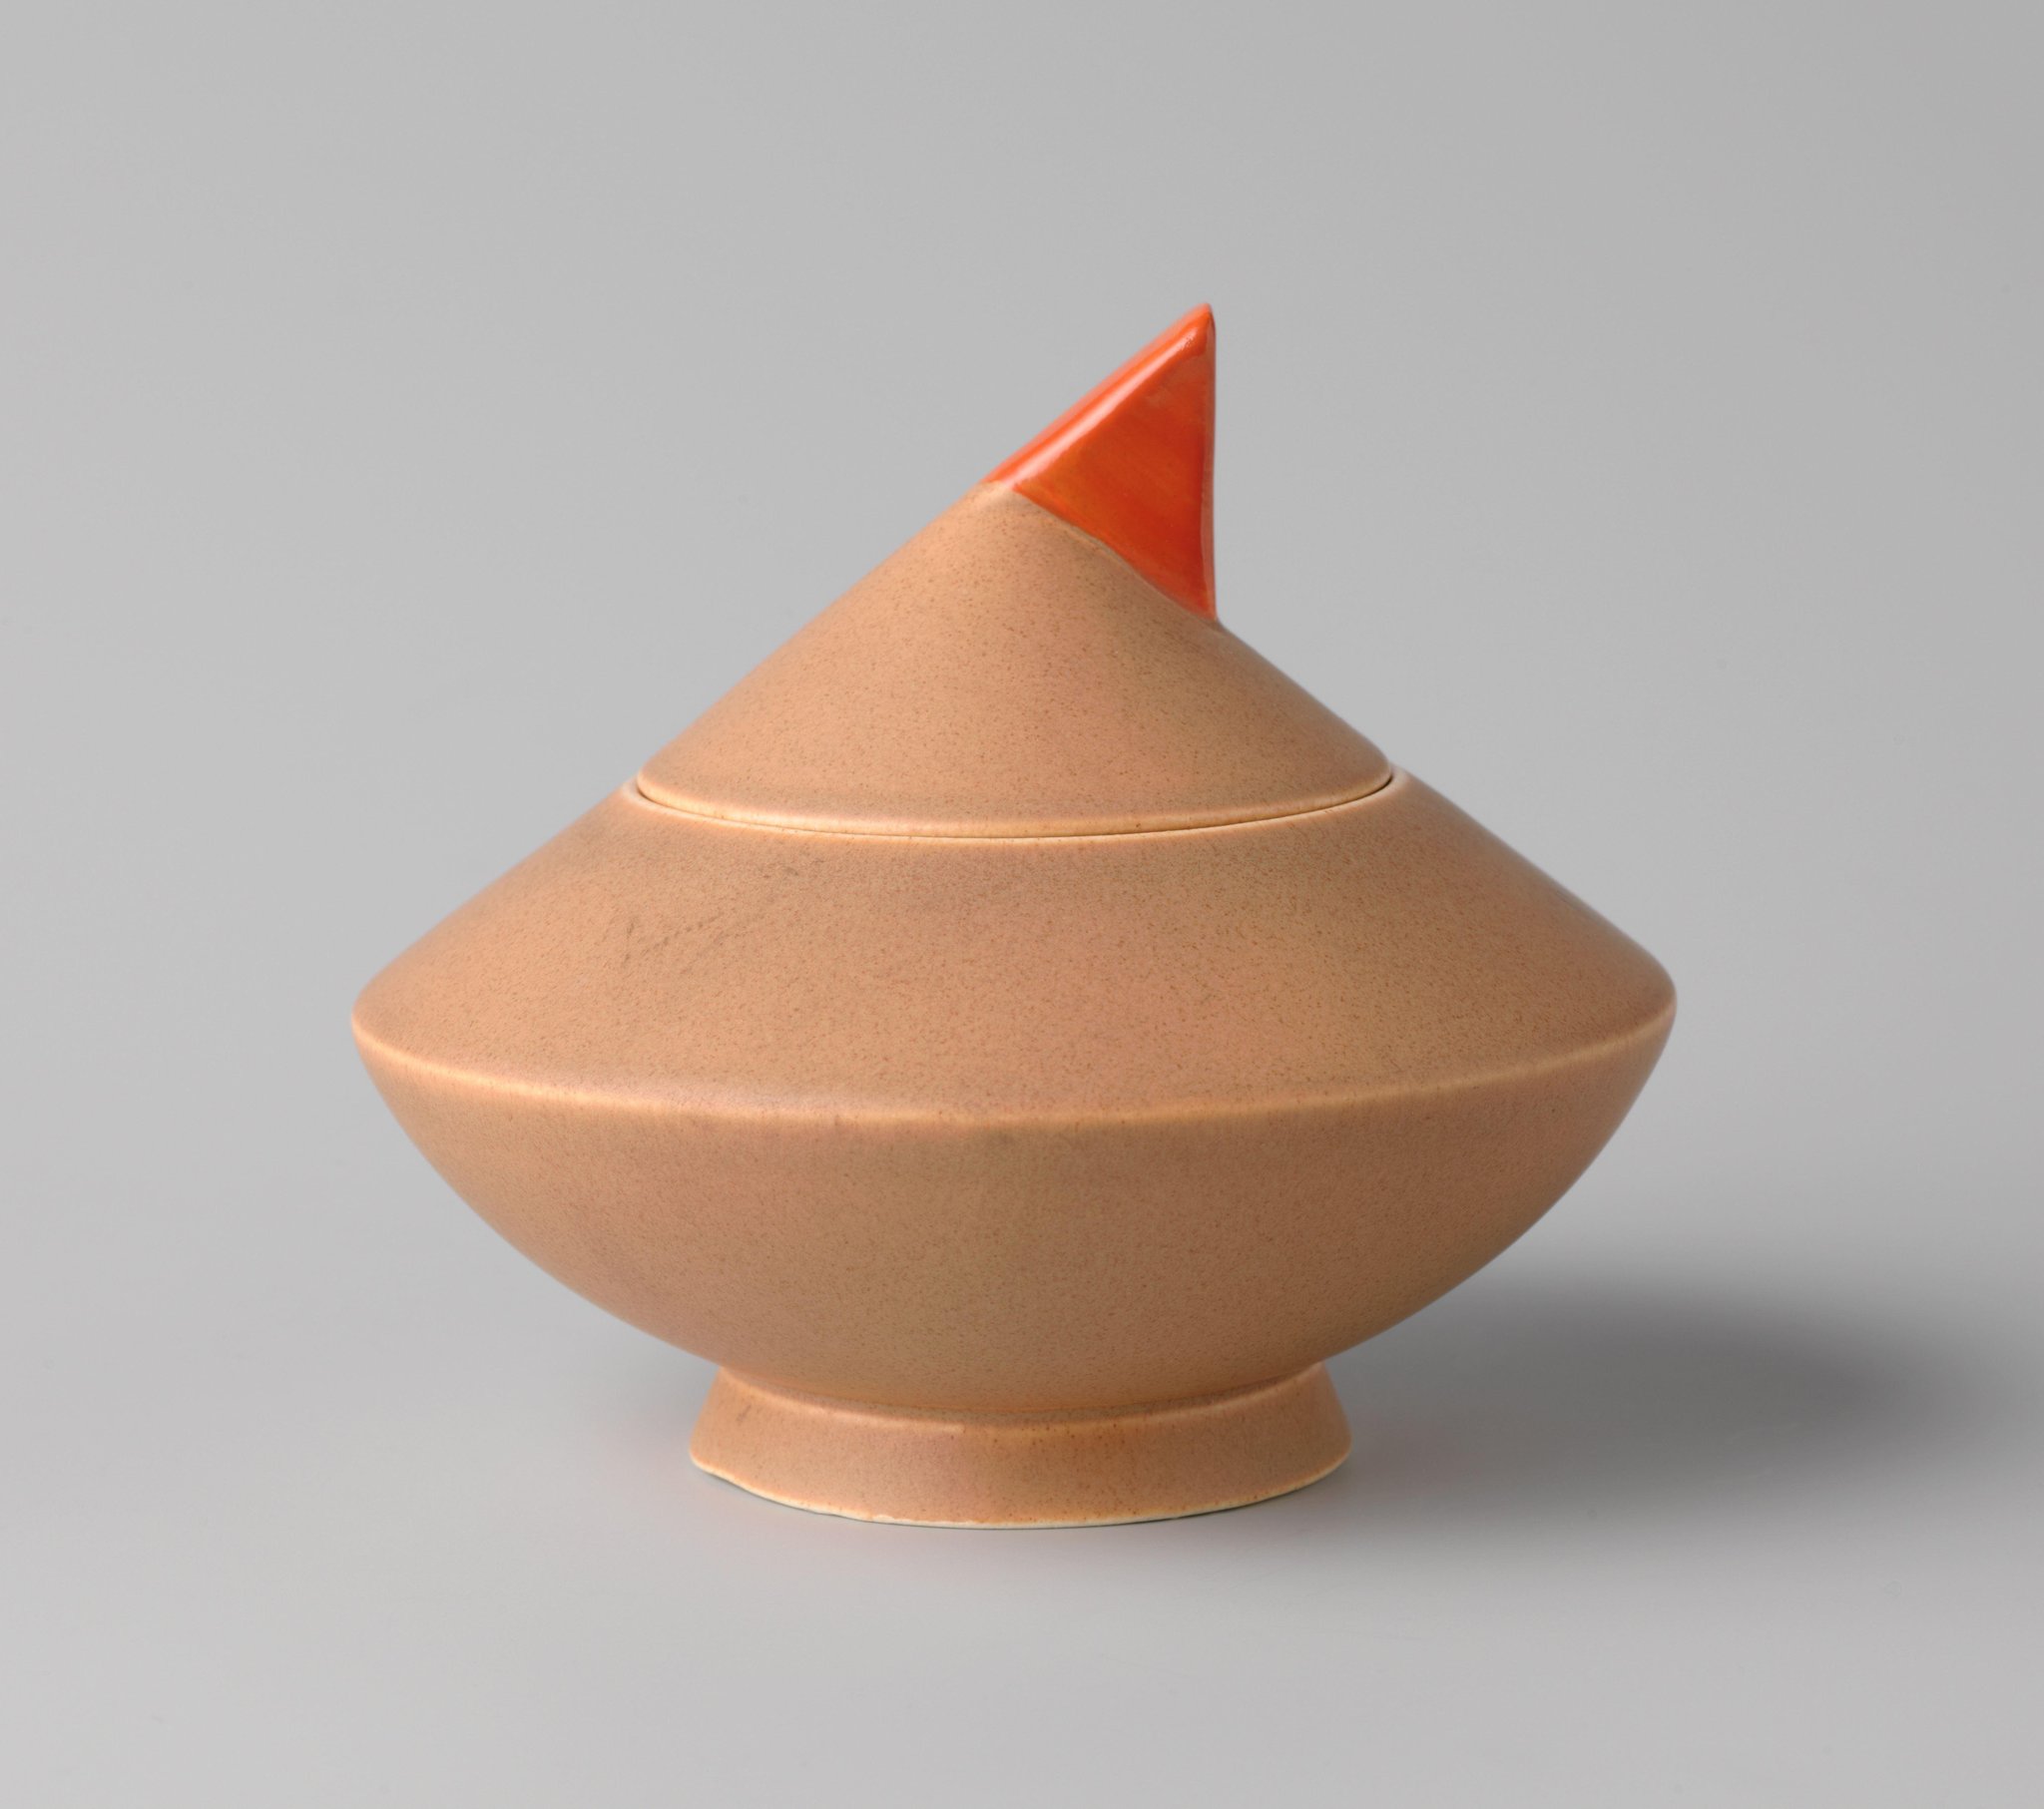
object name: sugar box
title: Deksel van suikerpot, deel van een theeservies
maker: edmond bellefroid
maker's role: ceramicist, painter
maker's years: 1893-1971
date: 1934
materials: earthenware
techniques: painted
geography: maastricht